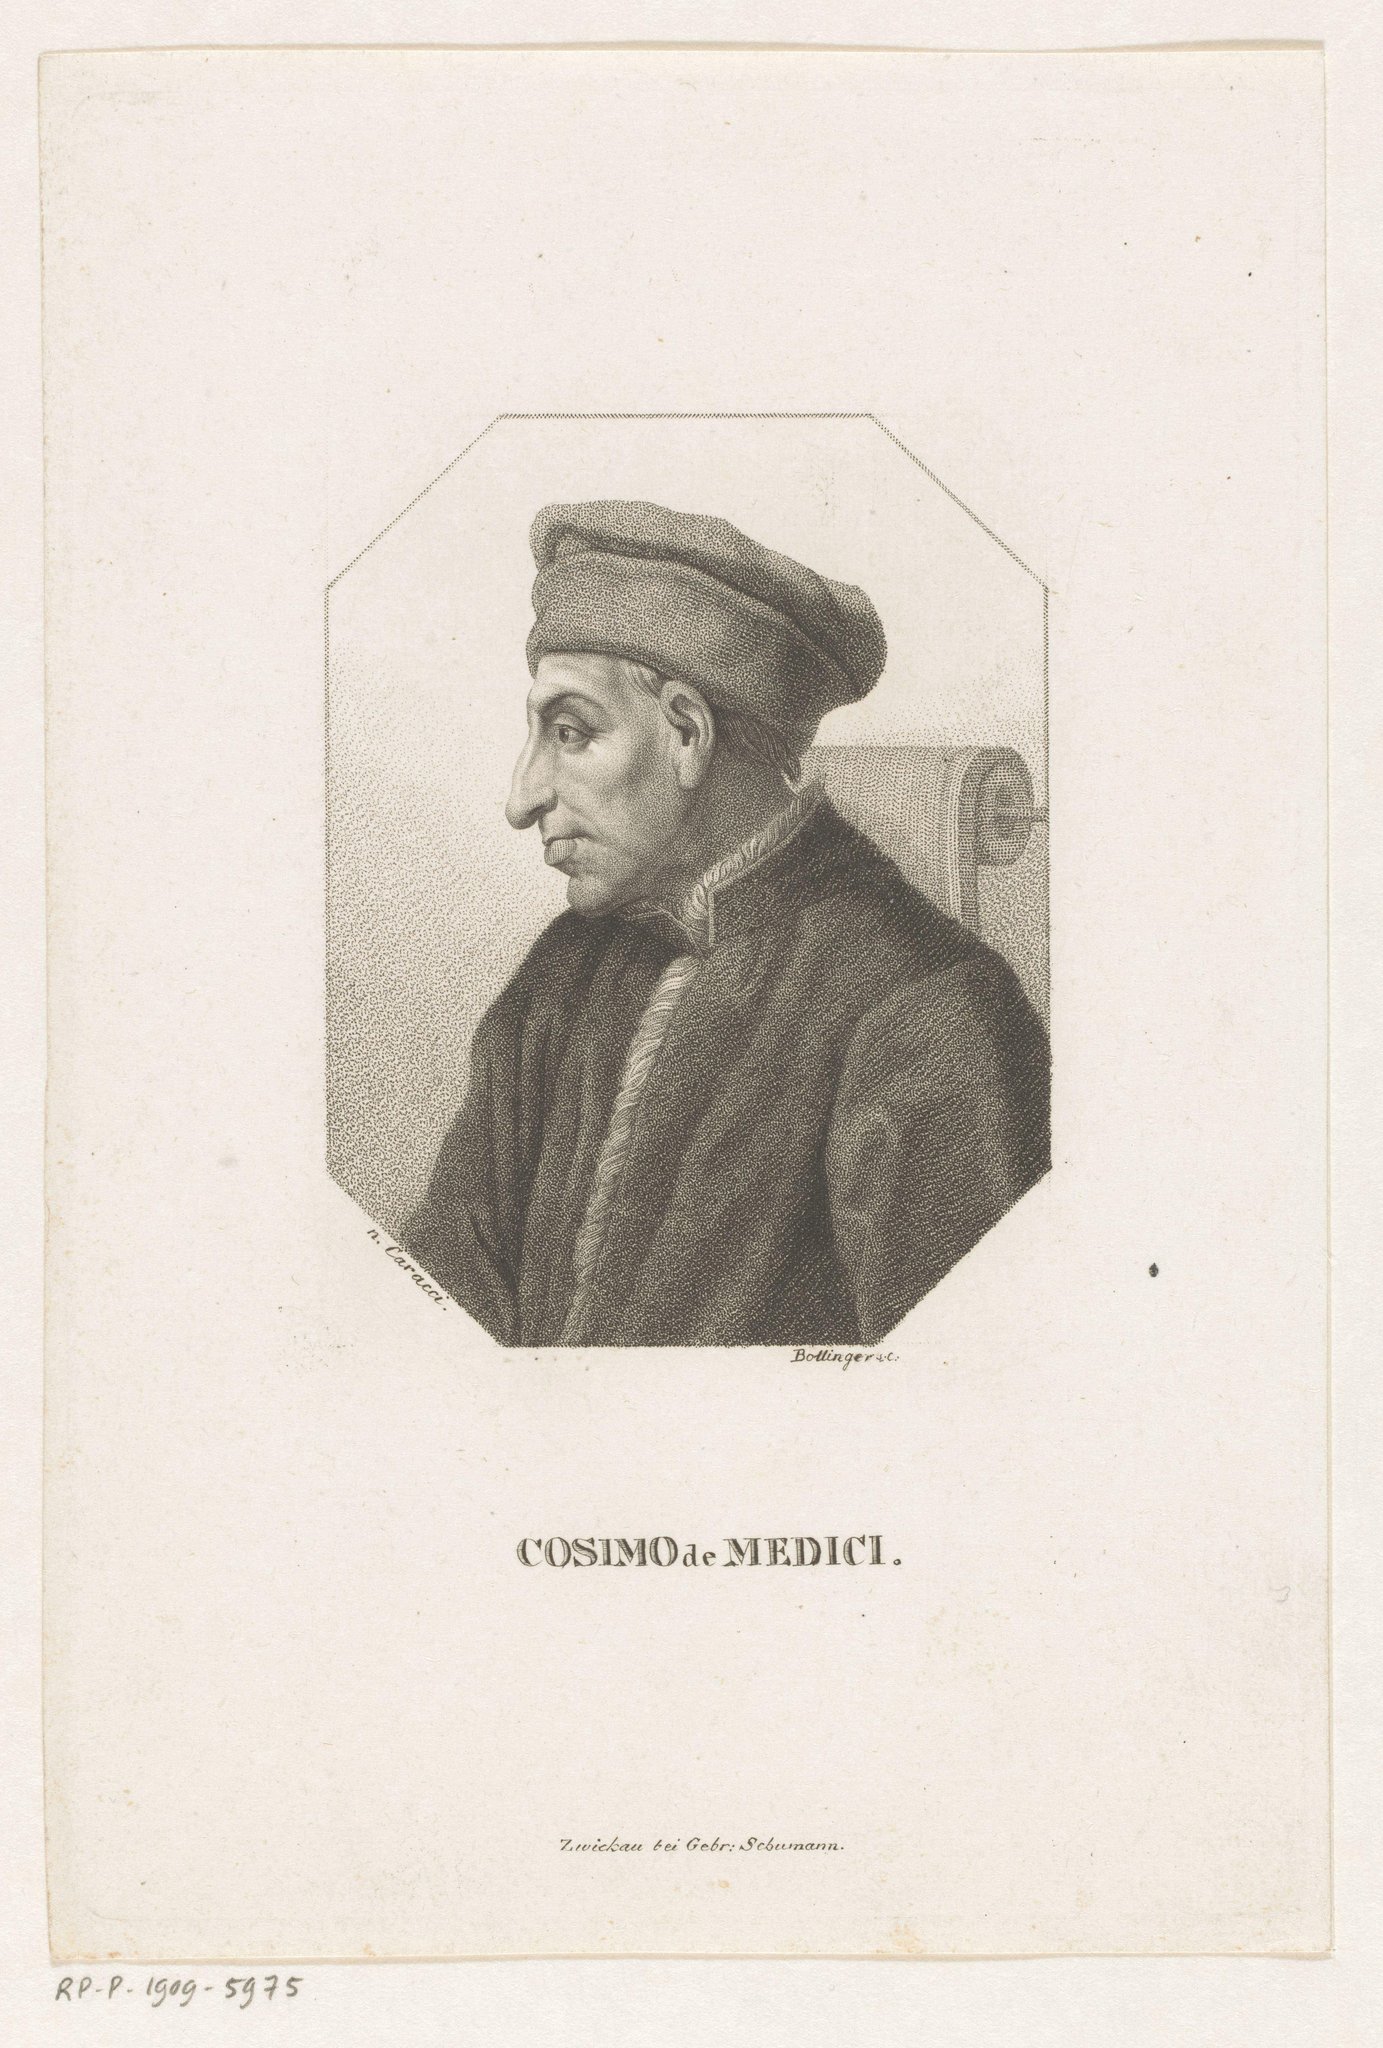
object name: print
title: Portretten van beroemde mensen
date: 1818-1832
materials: paper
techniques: stippling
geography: berlin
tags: politician, historical persons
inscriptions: collector's mark: Lugt 2228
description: Prent gebruikt door de serie 'Bildnisse der berühmtesten Menschen aller Völker und Zeiten' van de gebroeders Schumann, uitgegeven in 1818-1832 te Zwickau.